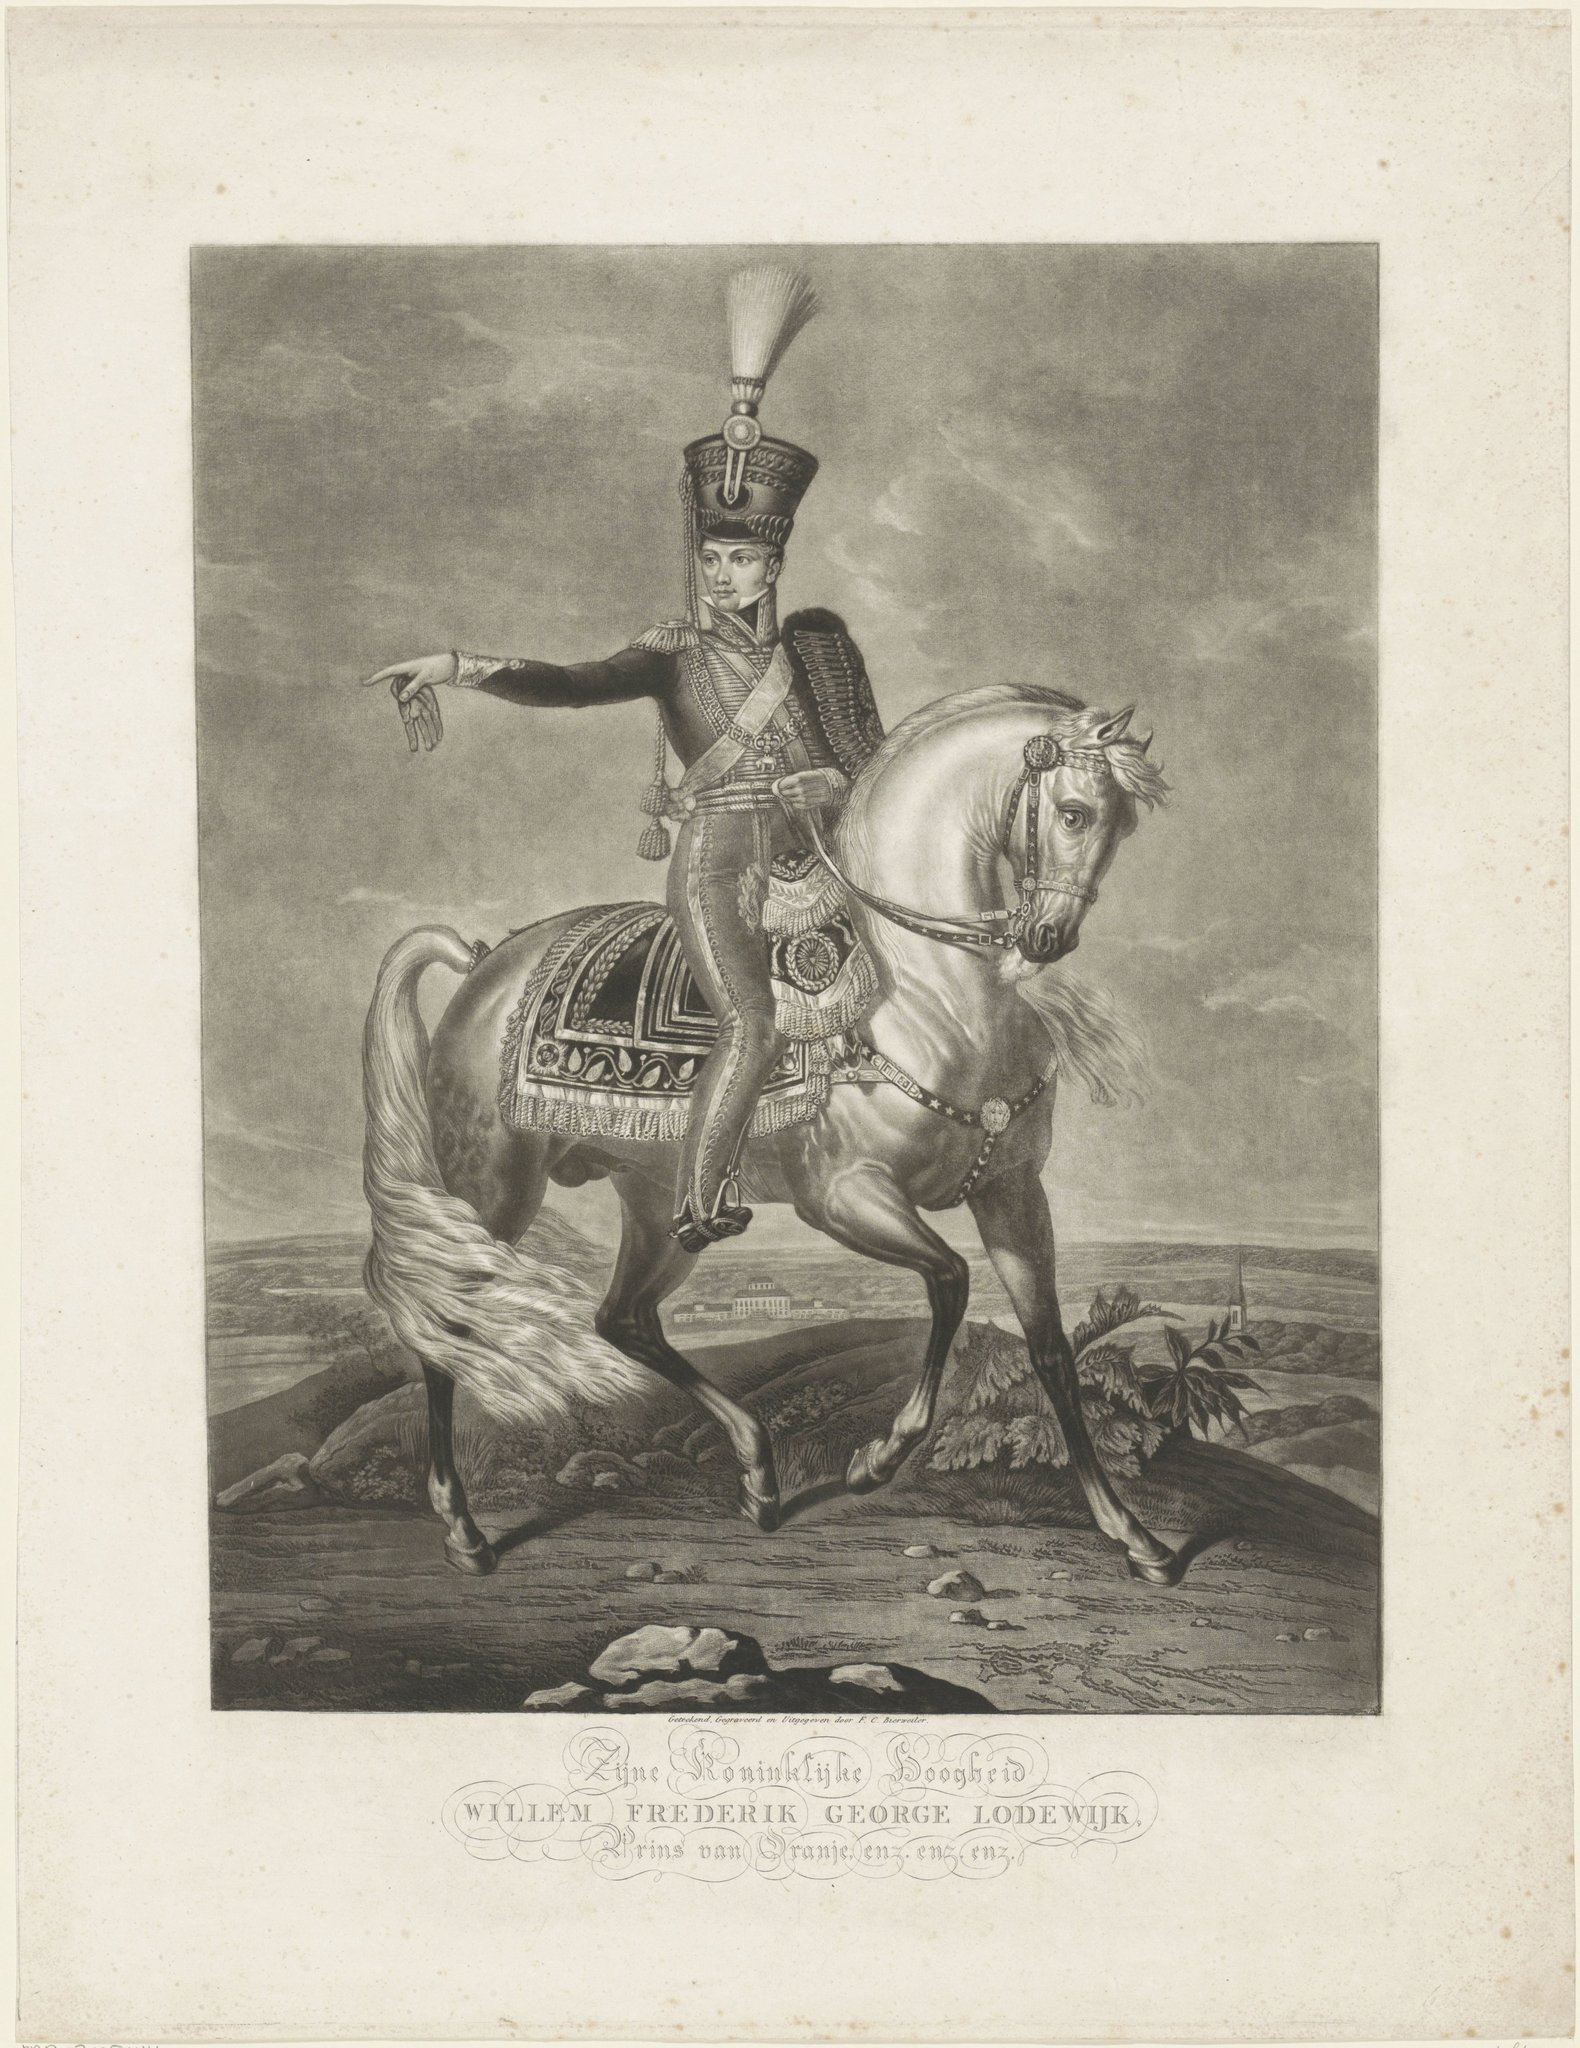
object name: print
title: Ruiterportret van Willem II, koning der Nederlanden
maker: frederik christiaan bierweiler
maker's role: print maker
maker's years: 1783-1831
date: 1810-1831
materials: paper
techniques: aquatint, etching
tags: the hague, william ii of the netherlands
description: De hier vermelde titel verwijst naar de hoogst verkregen titel van de geportretteerde, niet per se naar de titel die de geportretteerde op deze voorstelling draagt.